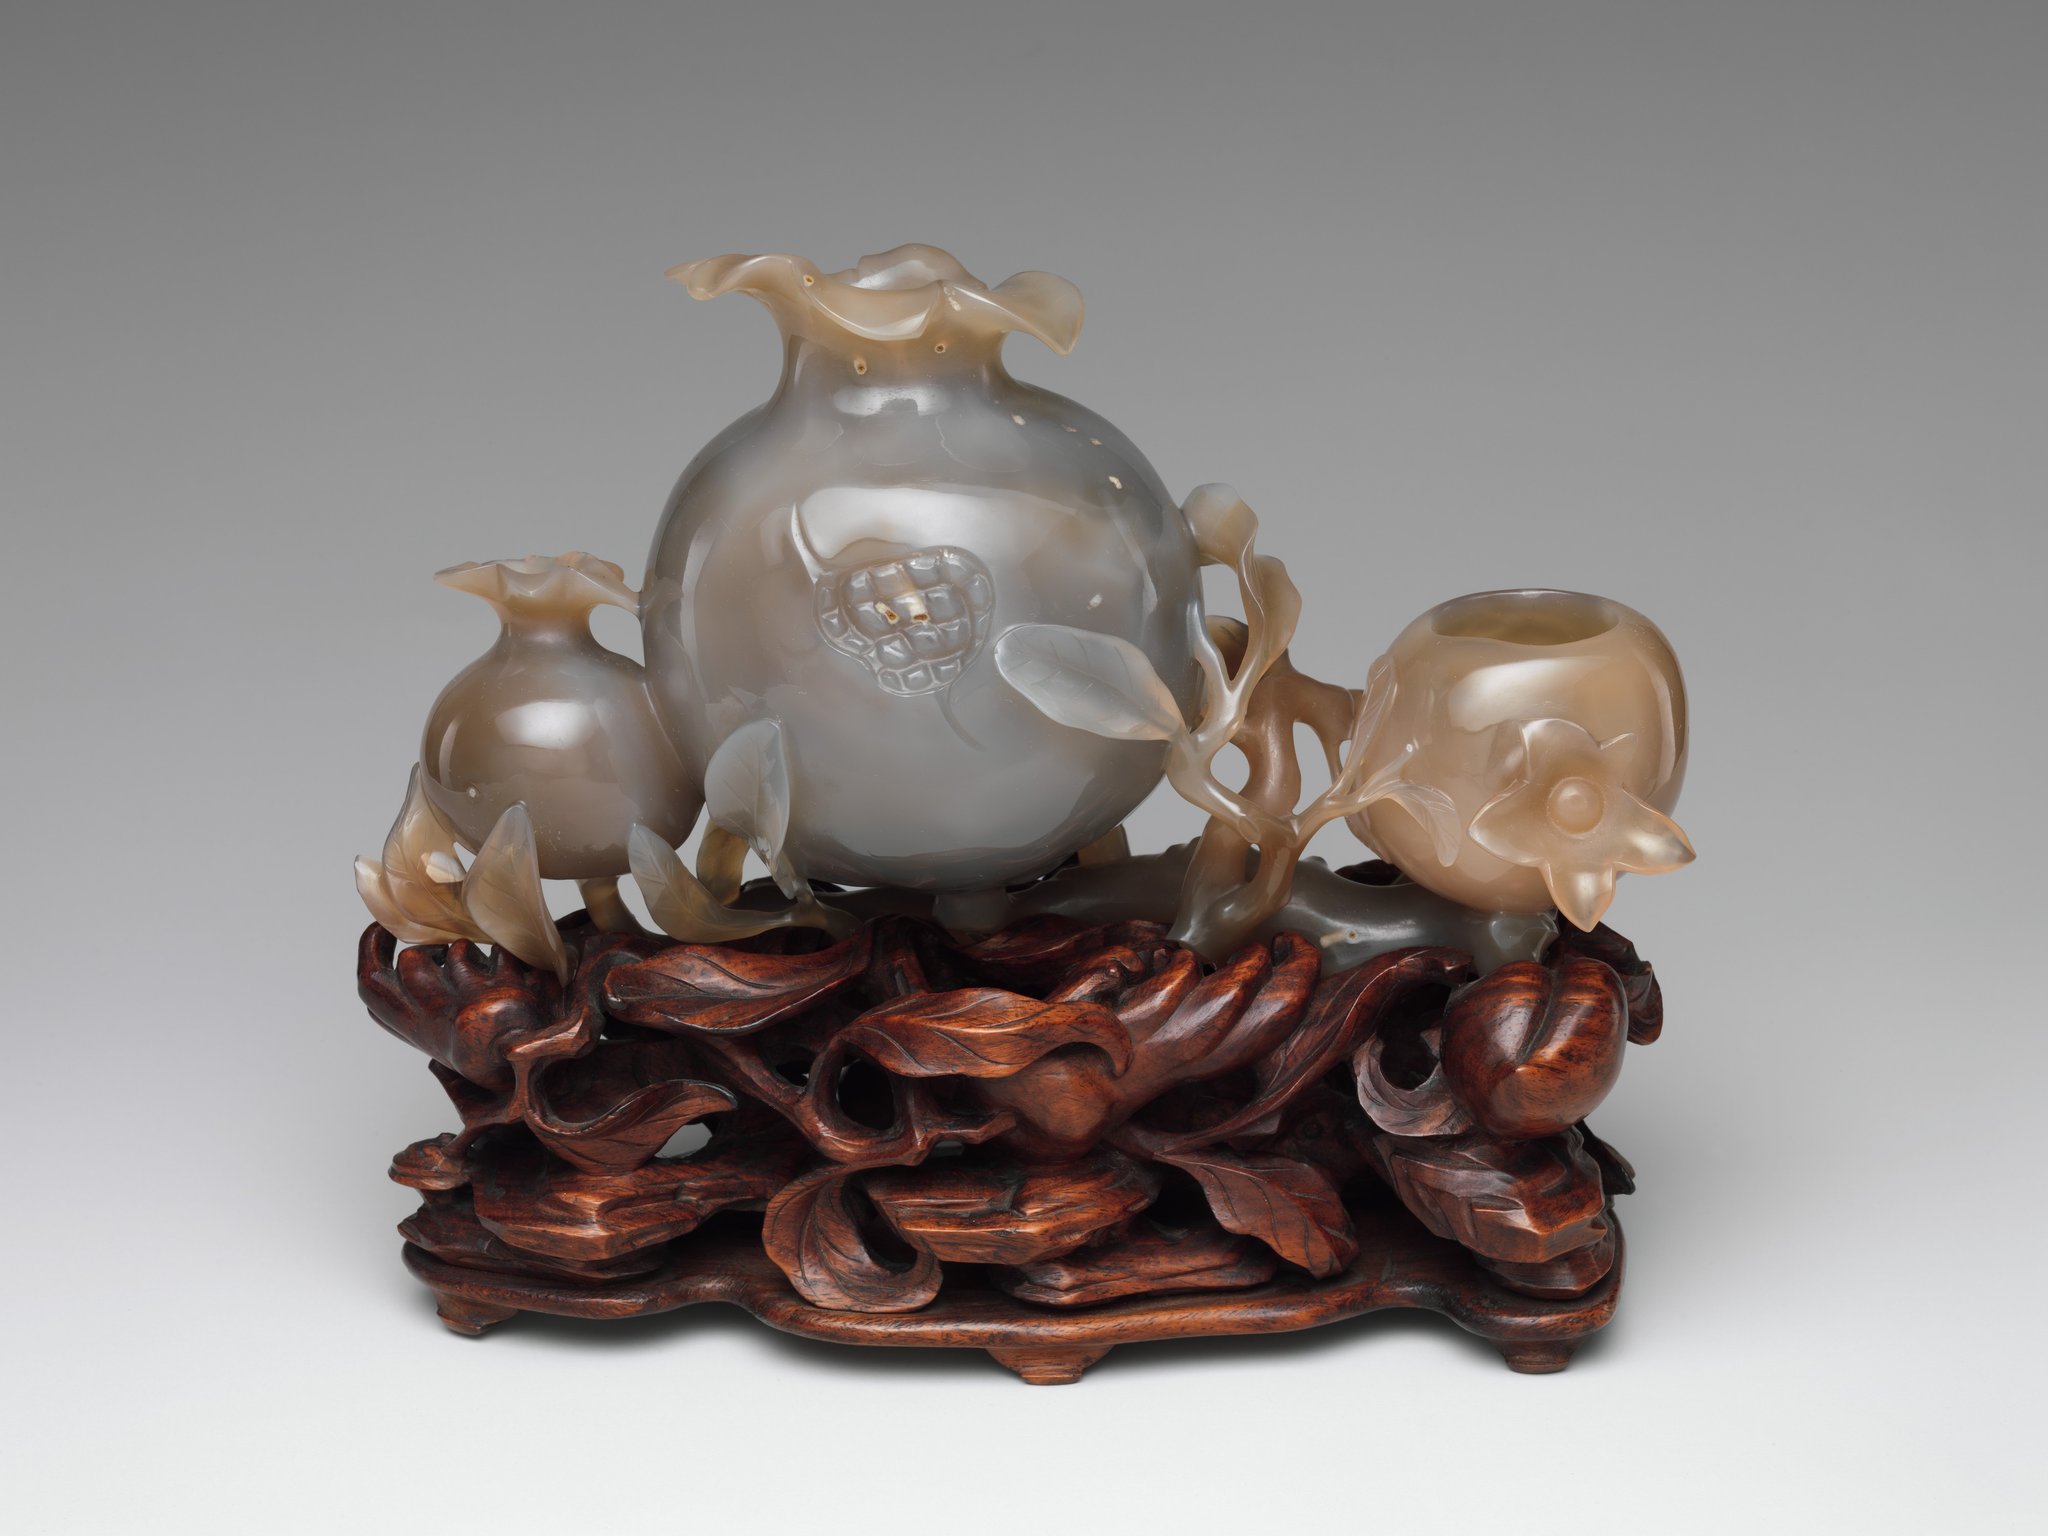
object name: water vessel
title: Pomegranates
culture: chinese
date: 1701-1800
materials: stone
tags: pomegranates,flowers